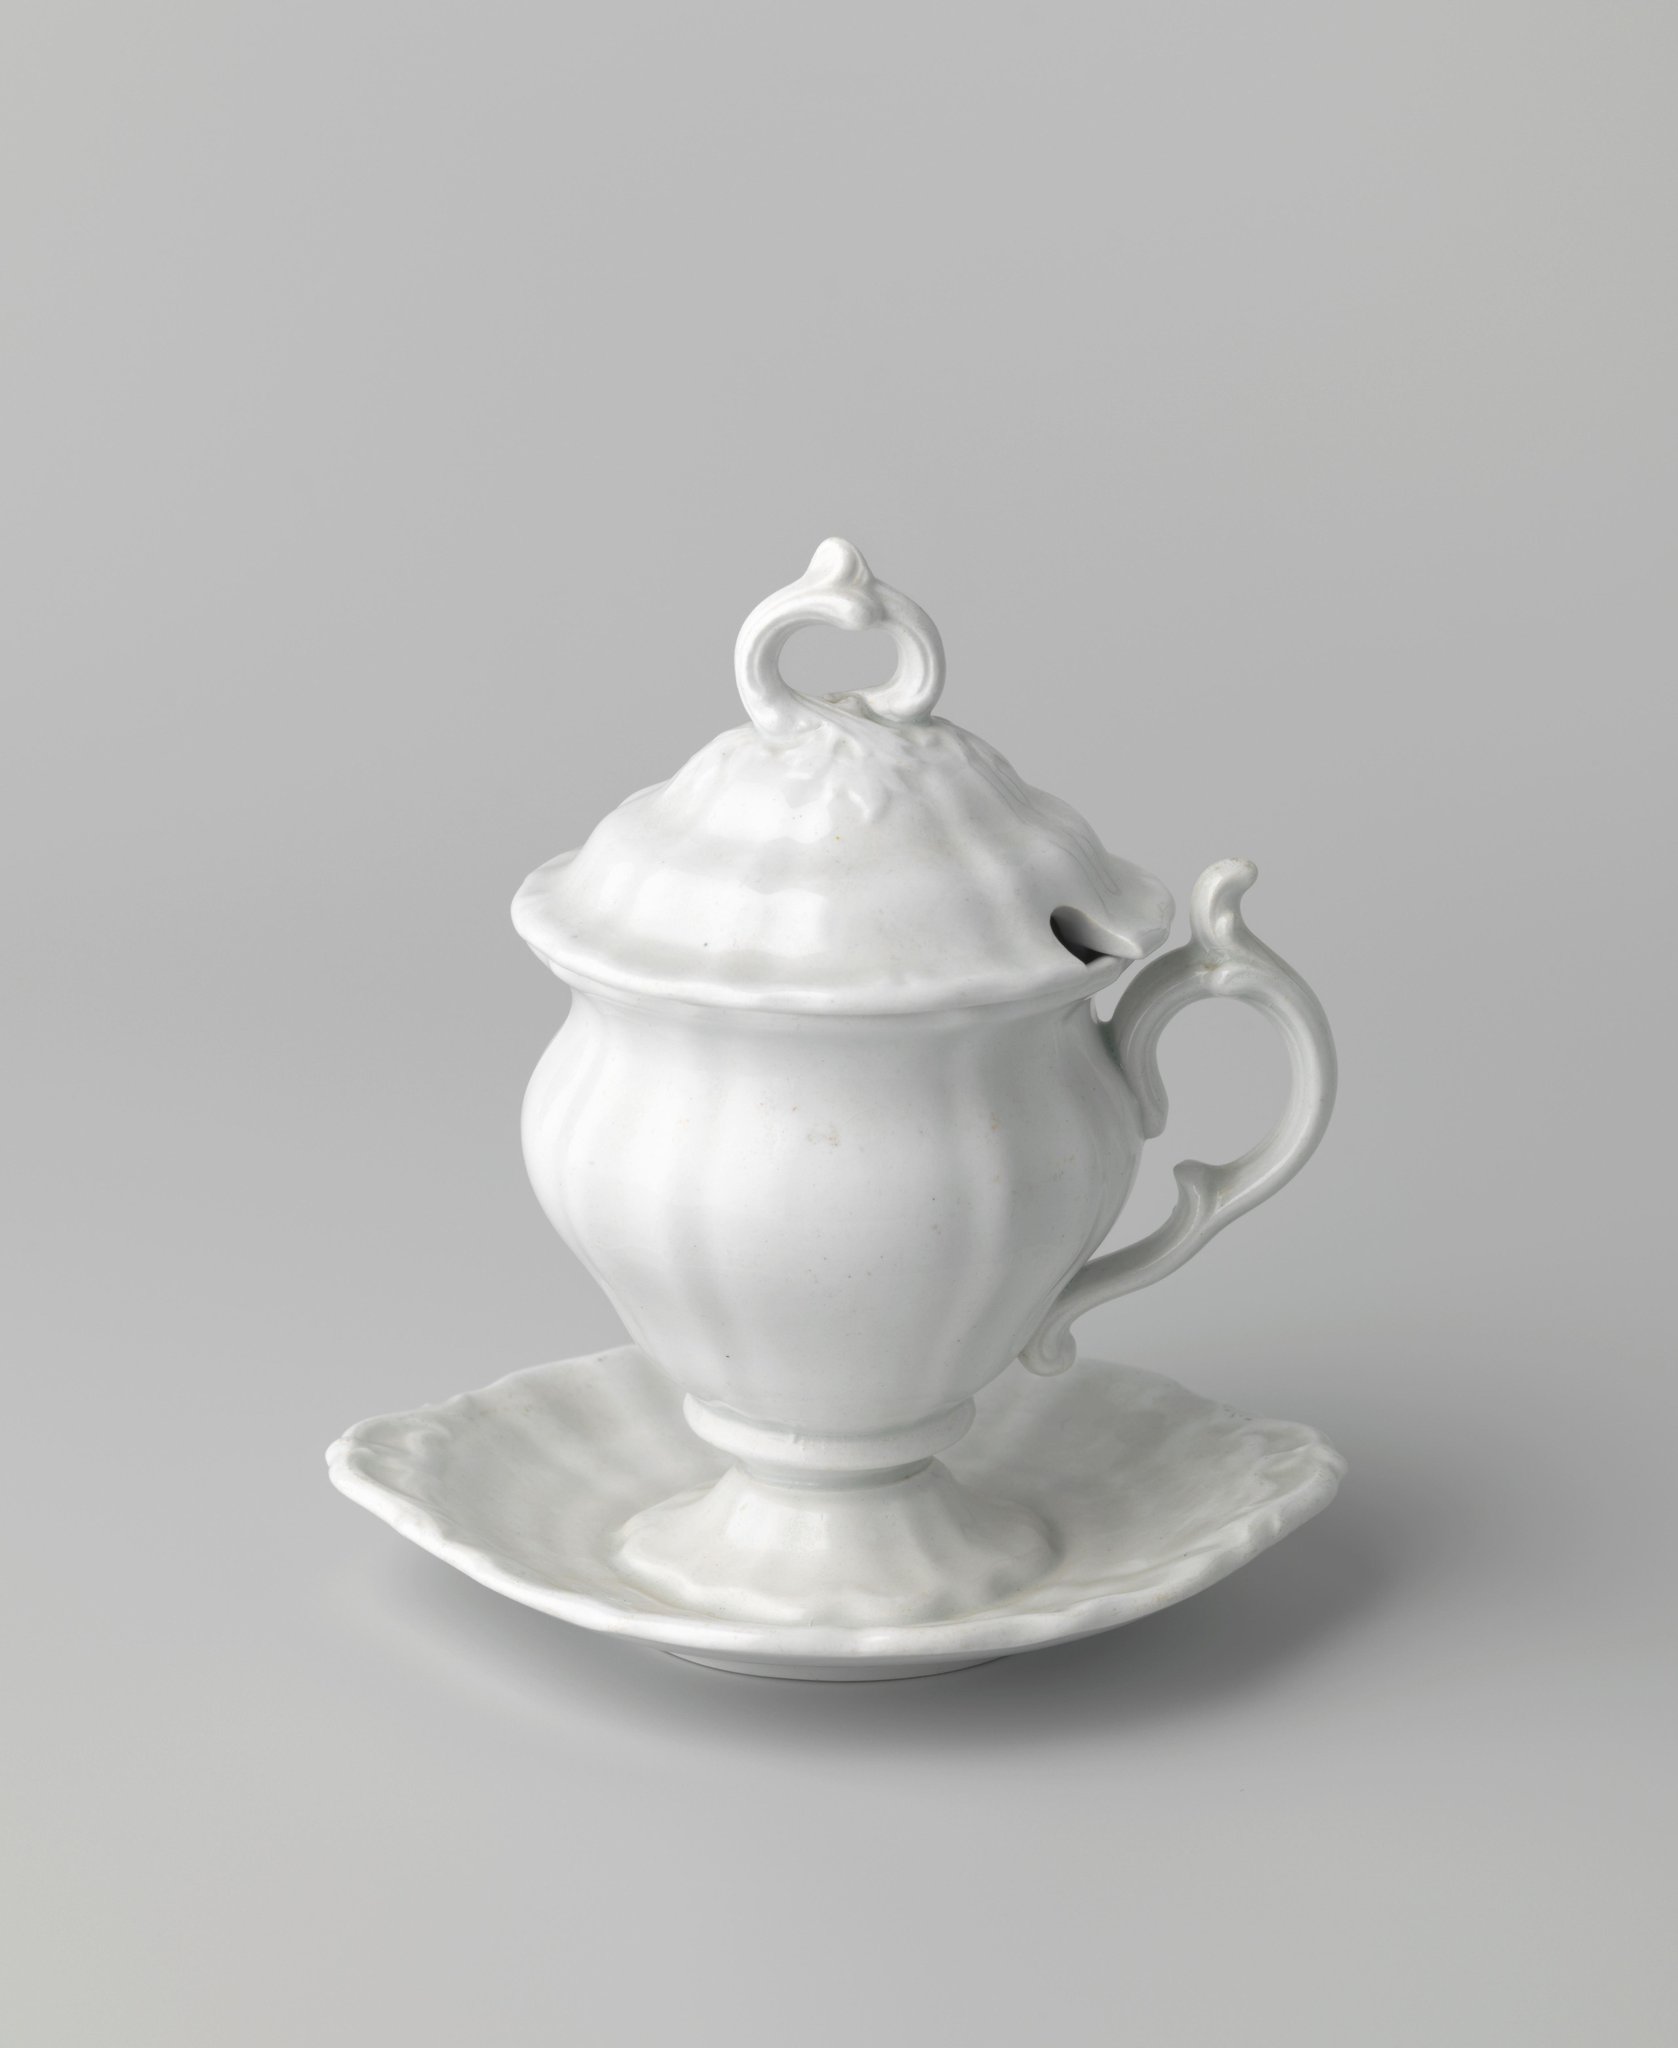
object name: lid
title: Deksel van mosterdpot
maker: petrus regout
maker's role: plateelbakker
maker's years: 1801-1879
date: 1860-1890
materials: earthenware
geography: maastricht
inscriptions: check stamp: ‘P. REGOUT // MAASTRICHT // 27X’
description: Het trapsgewijs gewelfde deksel wordt bekroond door een knop in de vorm van omgekruld bladwerk.